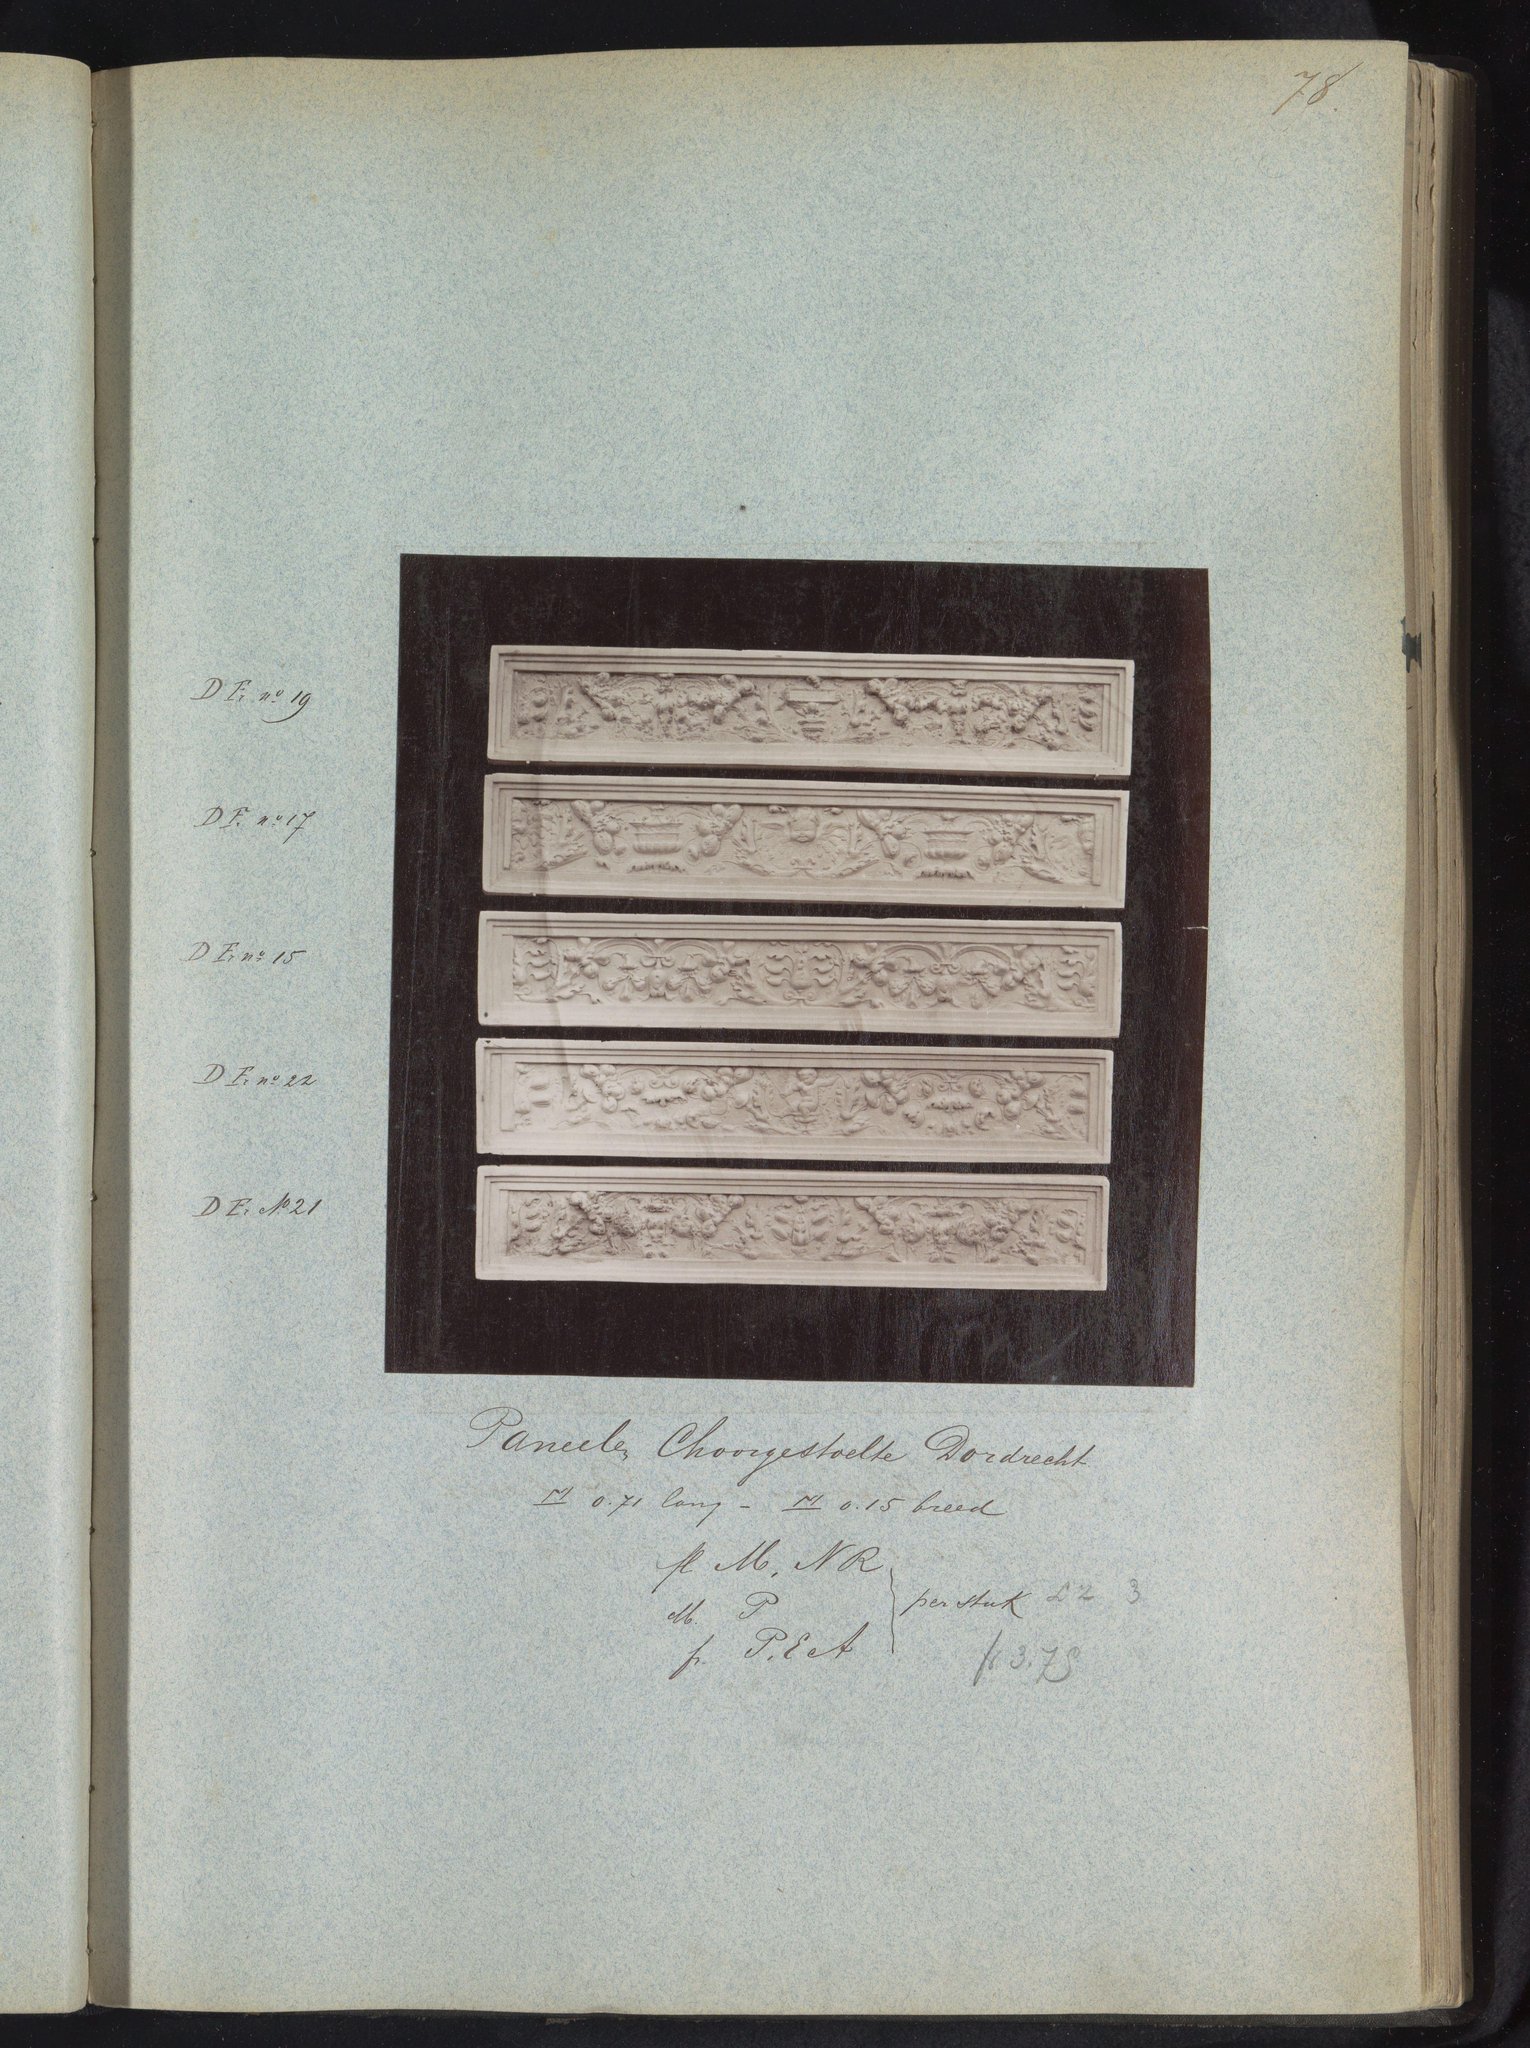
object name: photograph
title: Vijf gipsen afgietsels van panelen van een koorgestoelte, vermoedelijk van de Grote Kerk te Dordrecht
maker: Anonymous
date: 1875-1900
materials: paper, photographic support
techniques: albumen print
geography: dordrecht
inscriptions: annotation: ‘Panelen koorgestoelte Dordrecht / M 0.71 lang - M 0.15 breed’, annotation